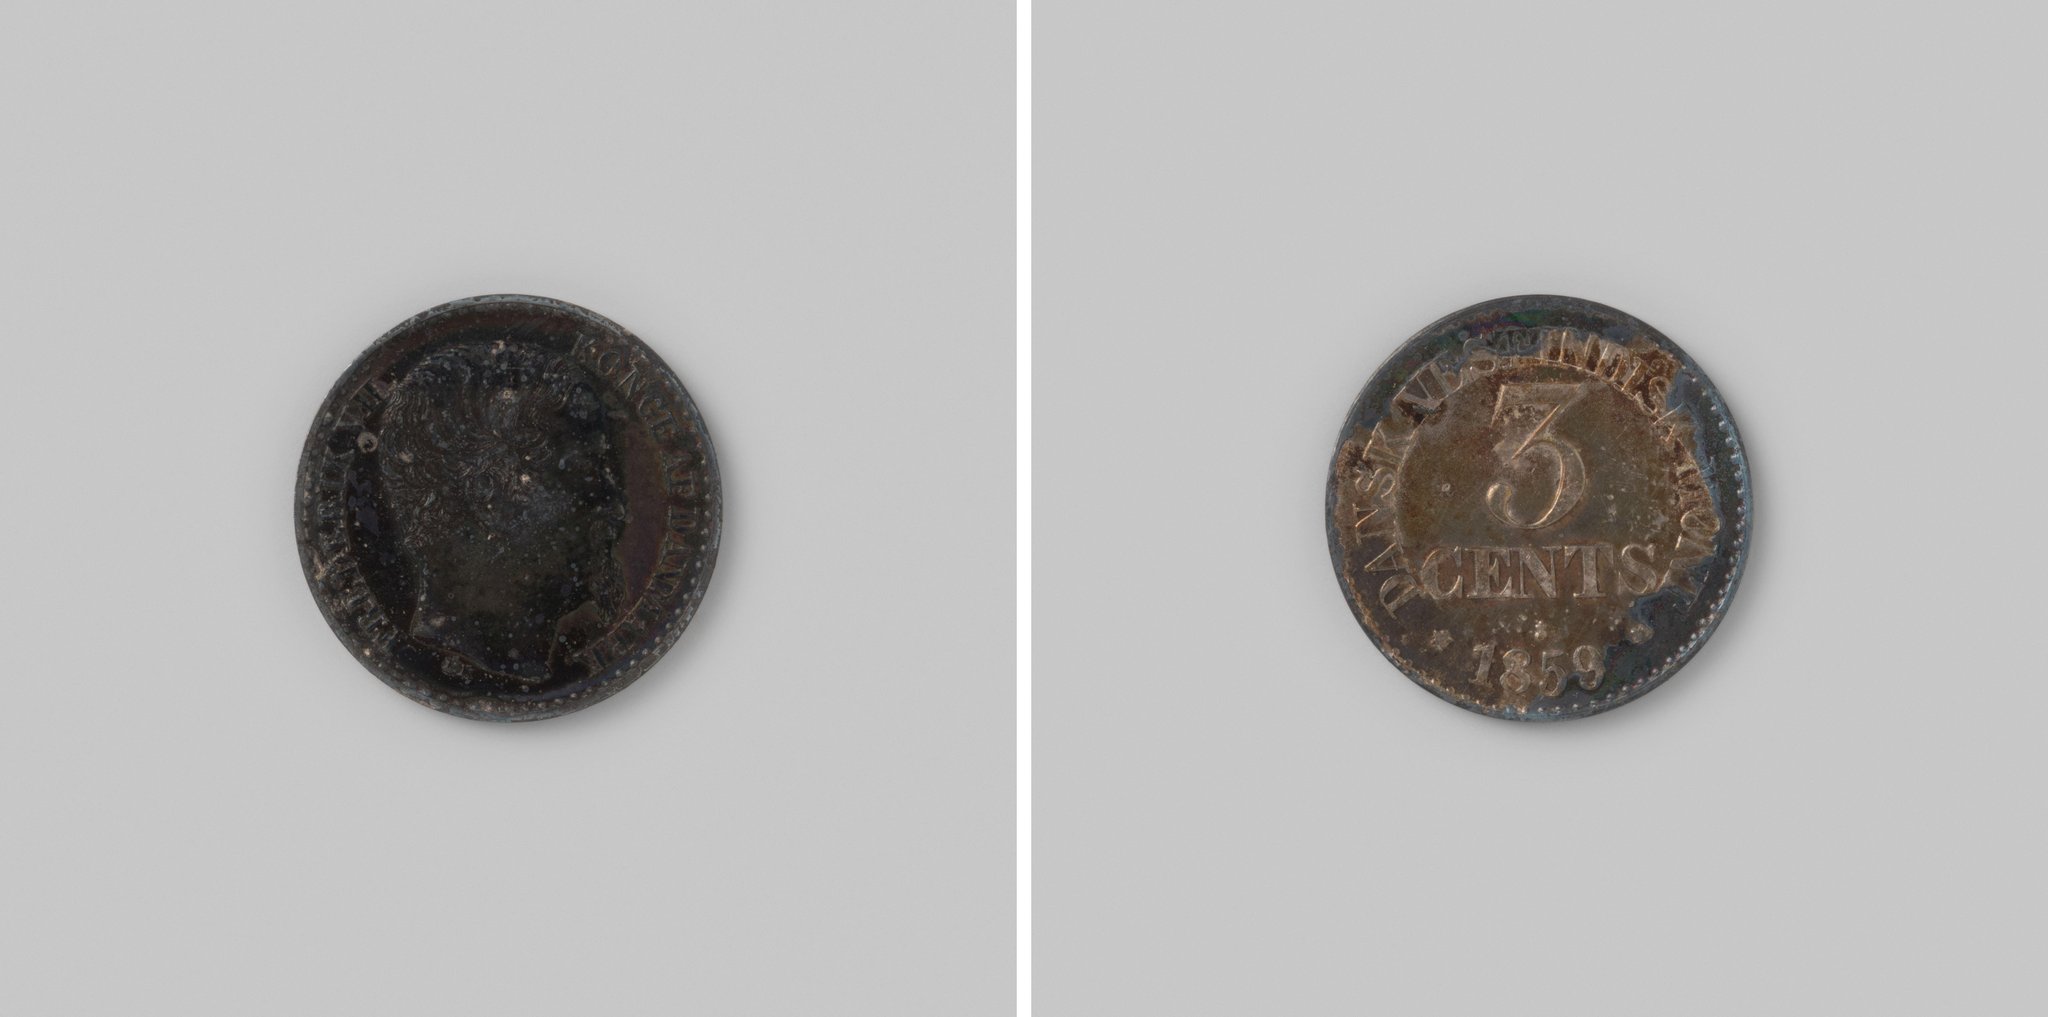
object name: coin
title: Deens West-Indië, koning Frederik V, 3 cents, 1859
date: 1859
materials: silver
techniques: striking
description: Zilveren munt. Voorzijde: hoofd van de koning naar rechts. Keerzijde: waarde-aanduiding in twee regels. Daaronder jaartal.Gladde rand.